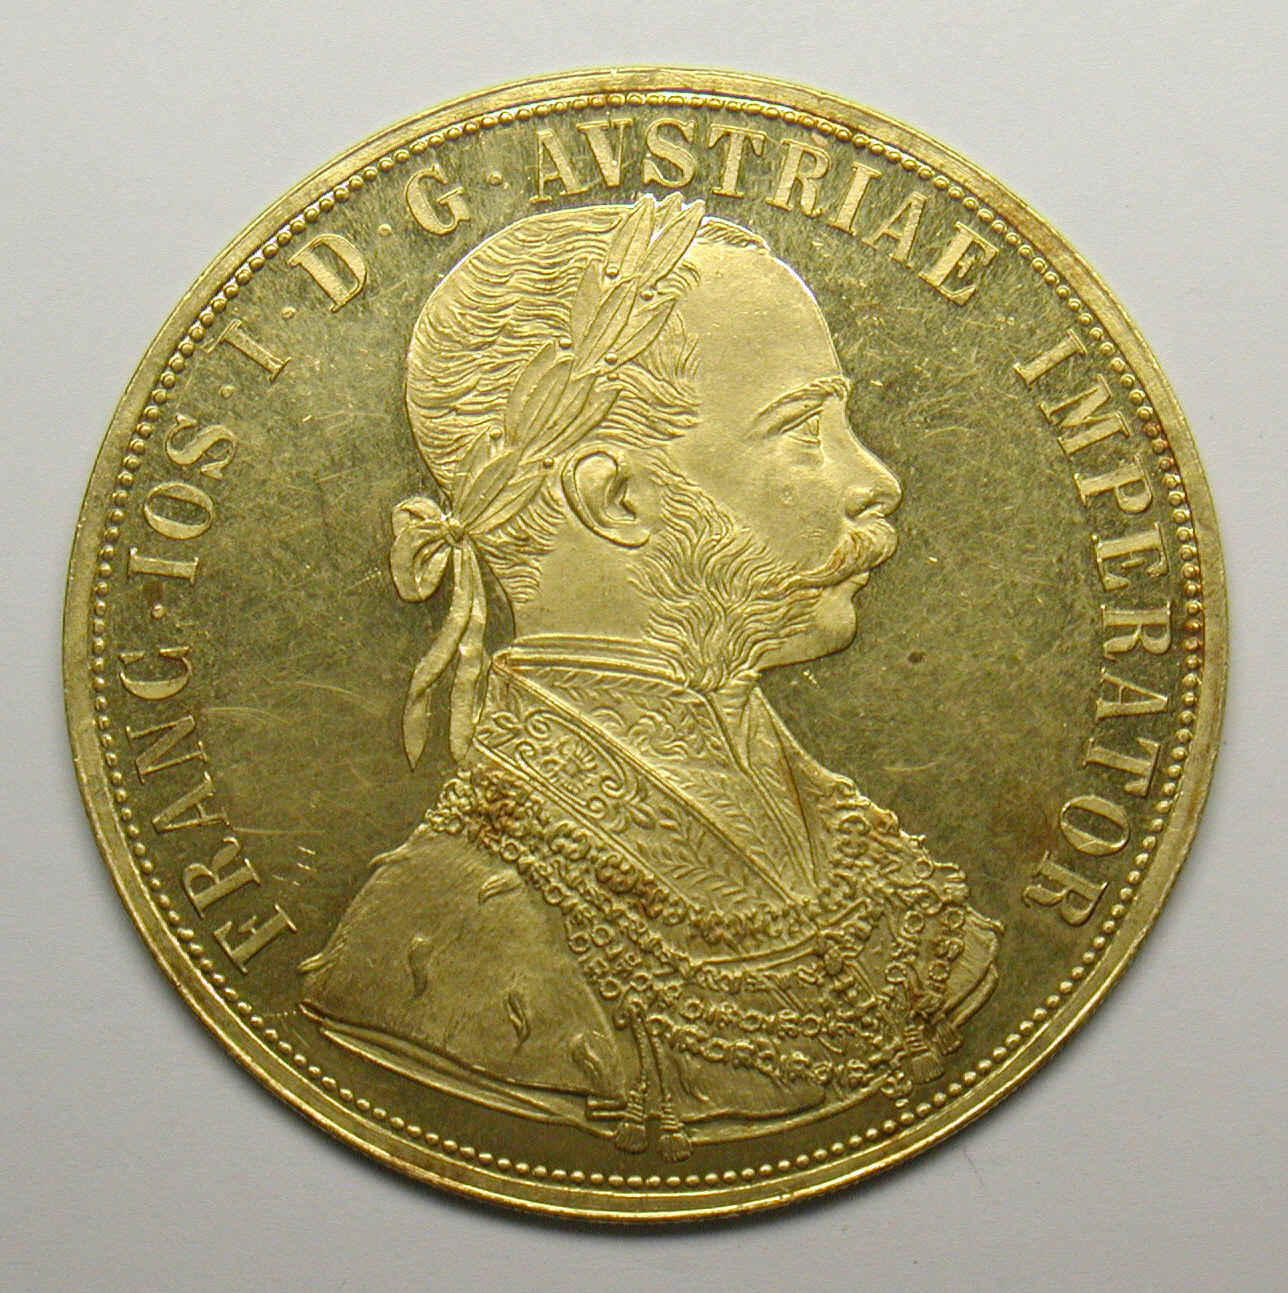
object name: ducat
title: 4-ducat piece, Francis Joseph I of Austria, 1888, 40th anniversary of the Emperor's accession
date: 1888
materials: gold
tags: kings,profiles